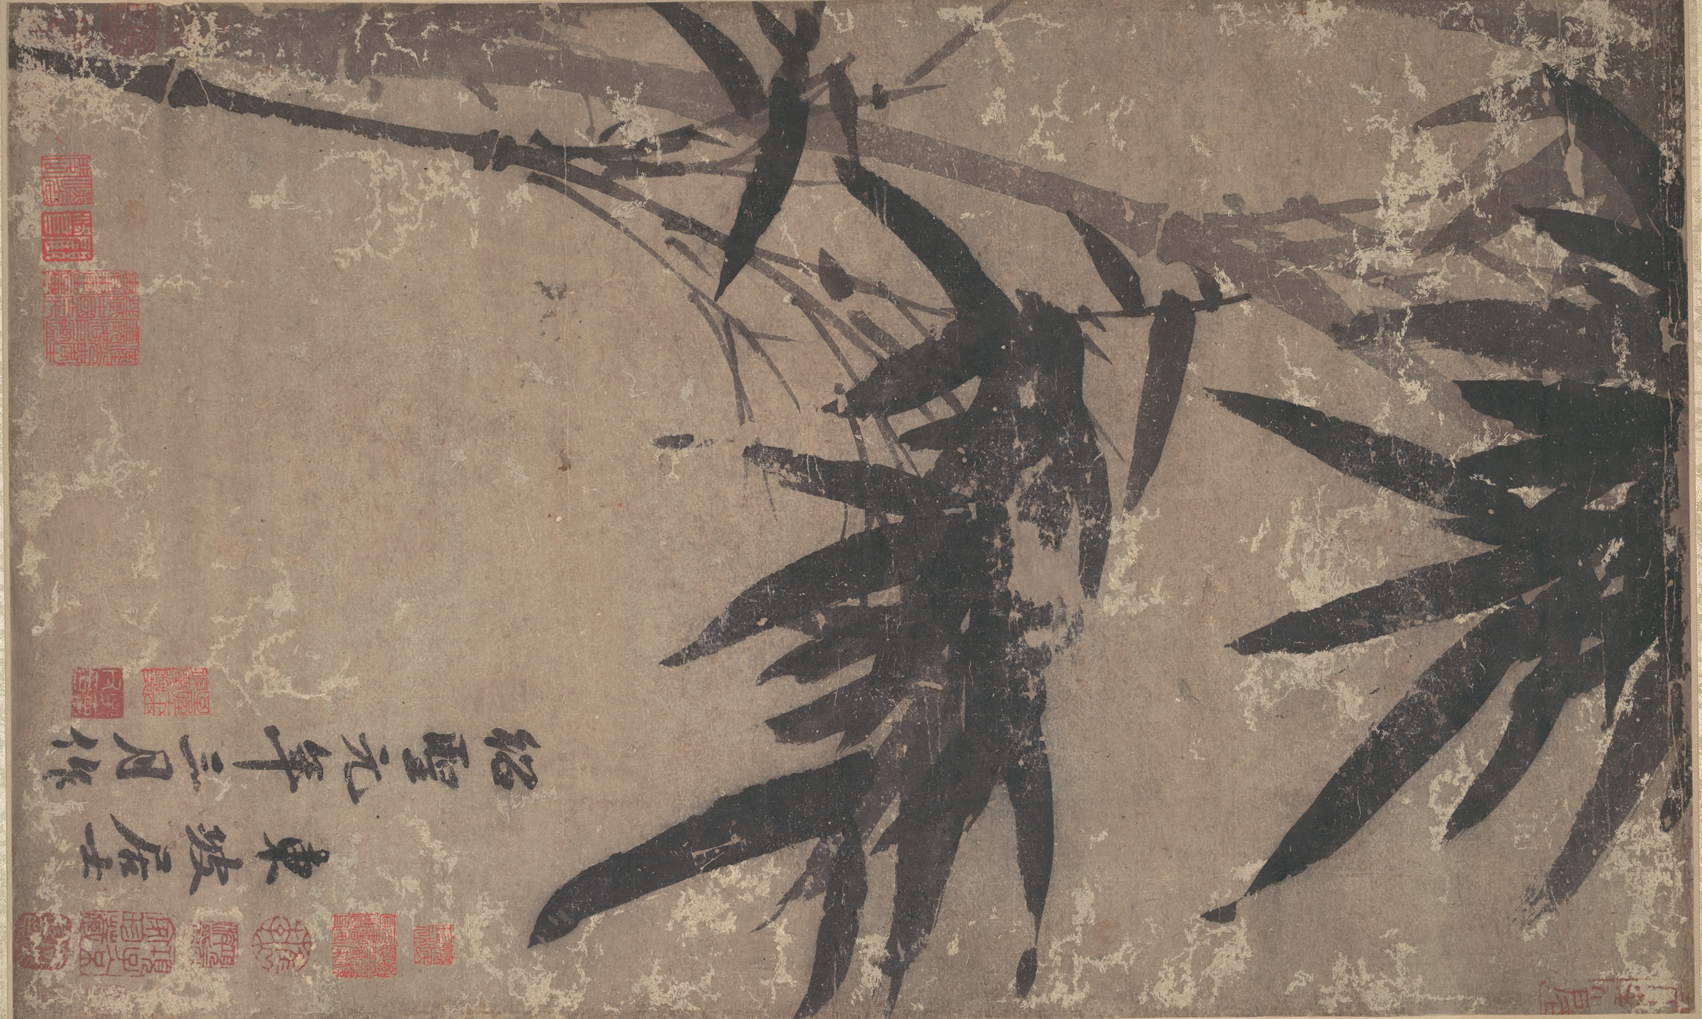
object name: hanging scroll mounted a handscroll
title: Bamboo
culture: chinese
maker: unidentified artist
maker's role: artist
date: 1037-1101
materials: ink, paper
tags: bamboo